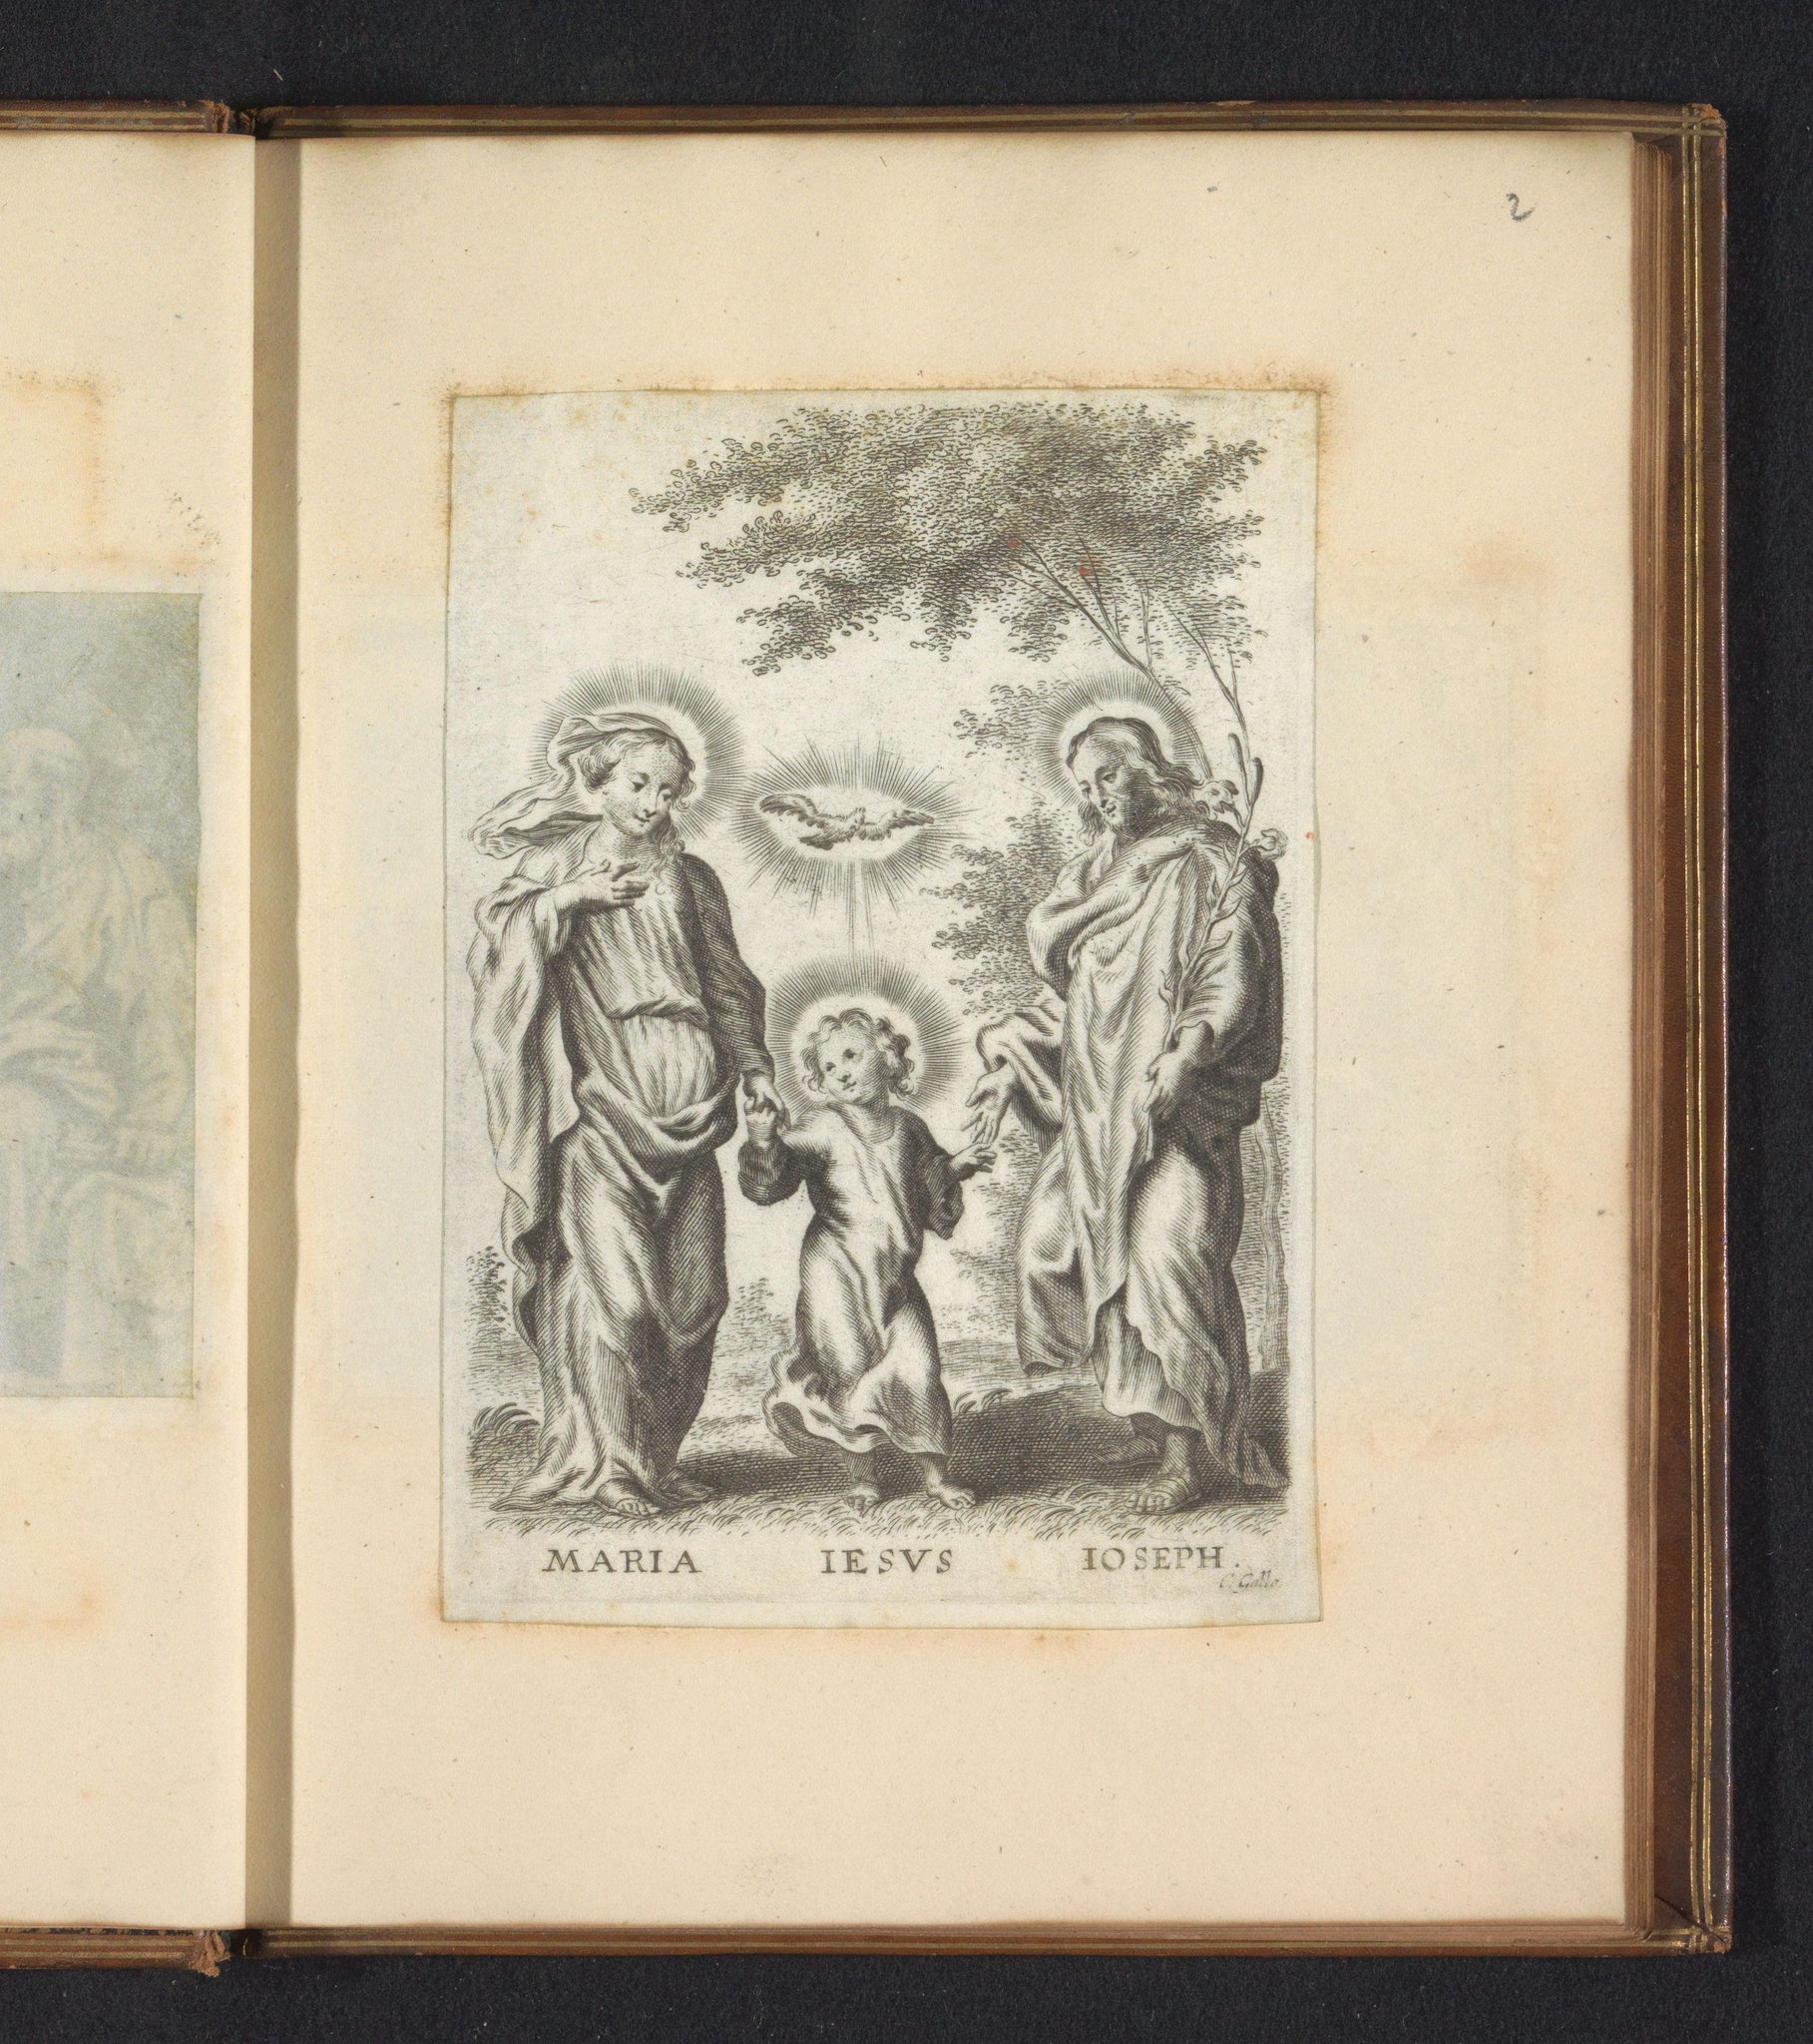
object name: print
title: Heilige Familie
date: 1640-1678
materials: paper, parchment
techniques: engraving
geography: antwerp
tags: holy family (alone), 'trinitas terrestris'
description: De Heilige Familie, boven Christus zweeft de duif van de Heilige Geest. Eén prent uit prentalbum met negentien devotionele prenten op perkament.